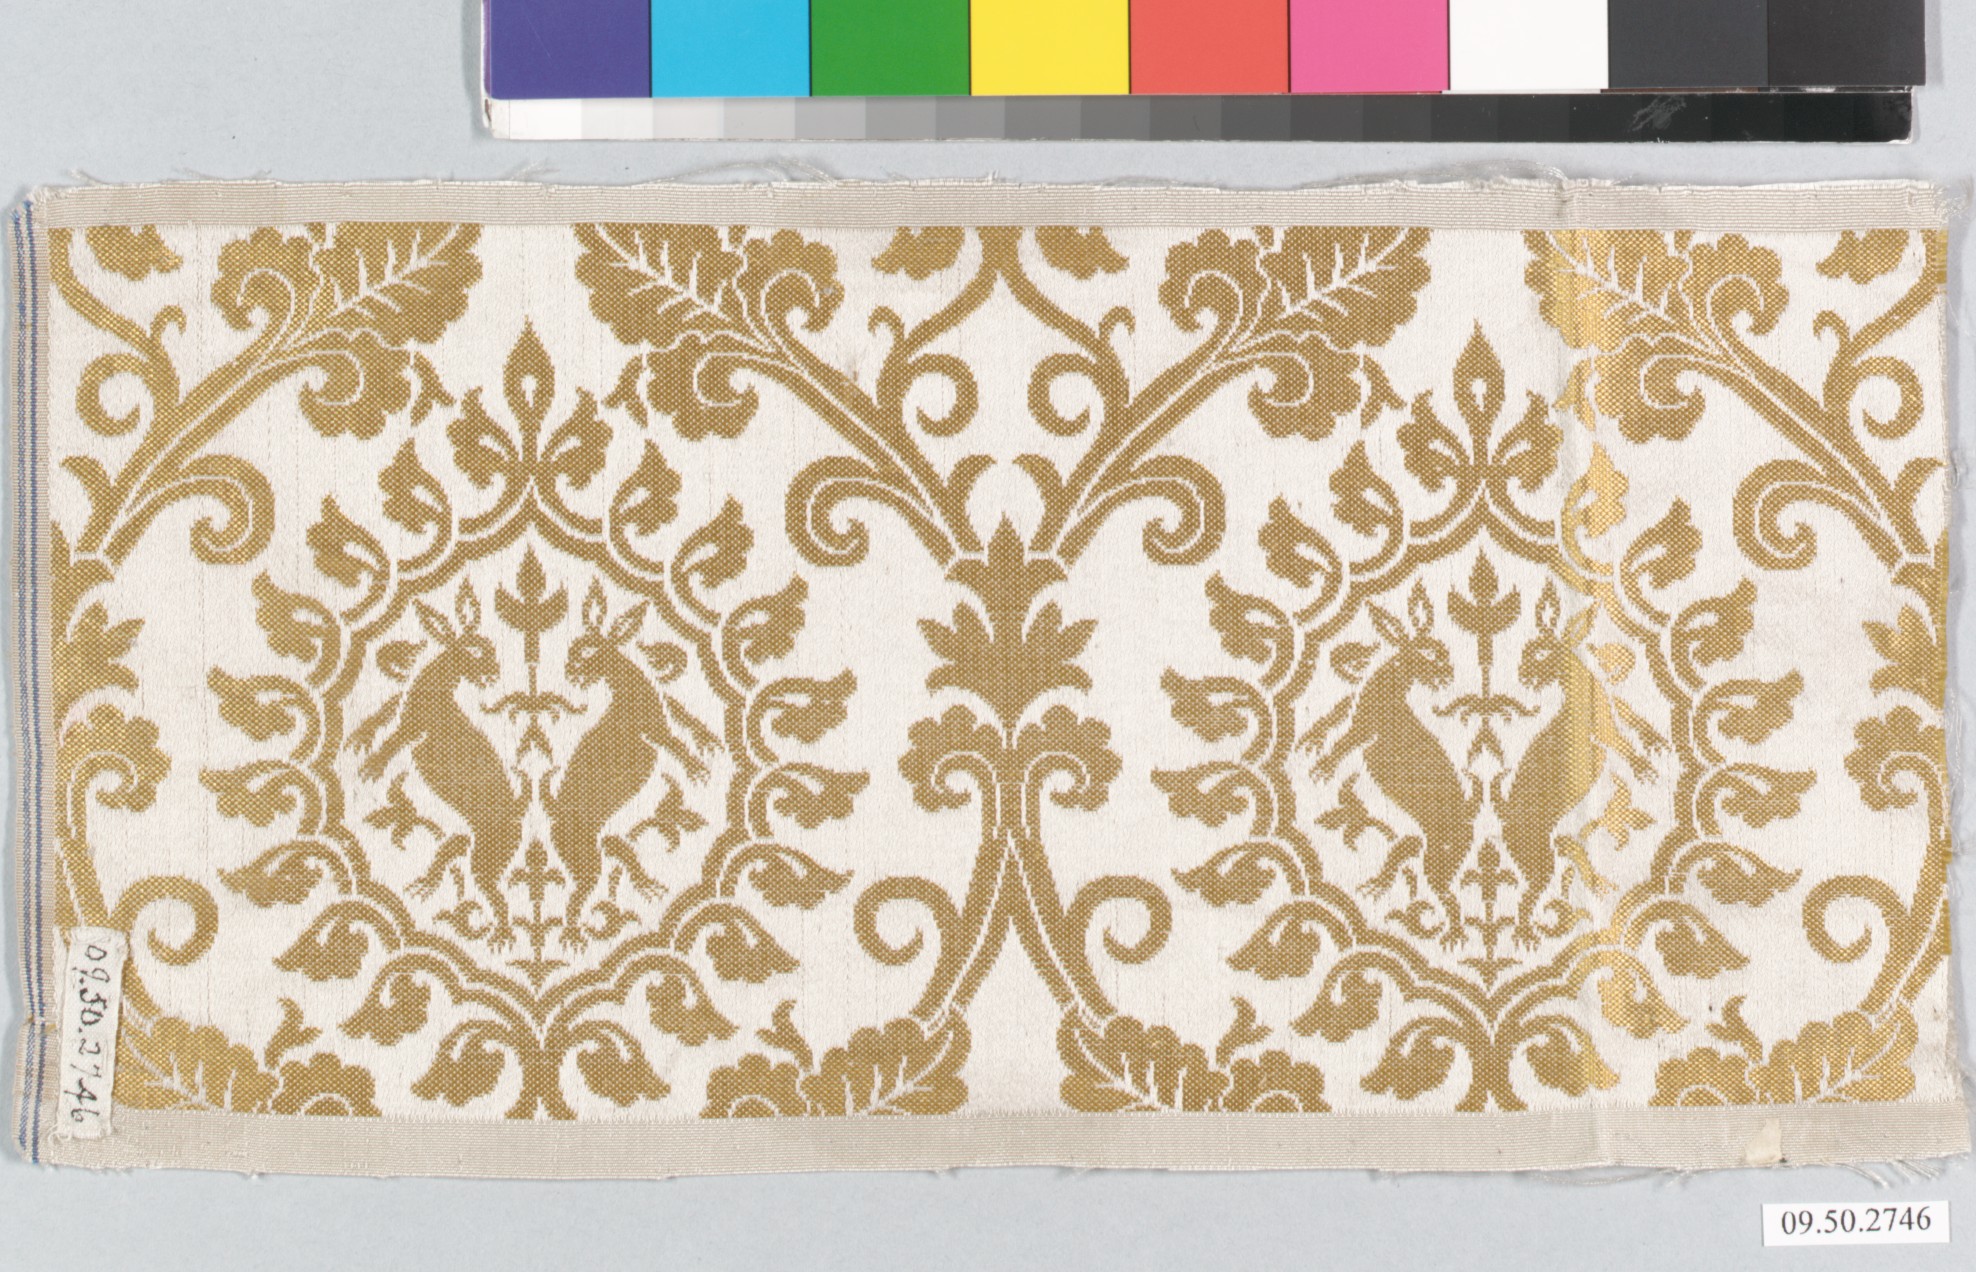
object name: piece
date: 1801-1900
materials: silk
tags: animals,leaves